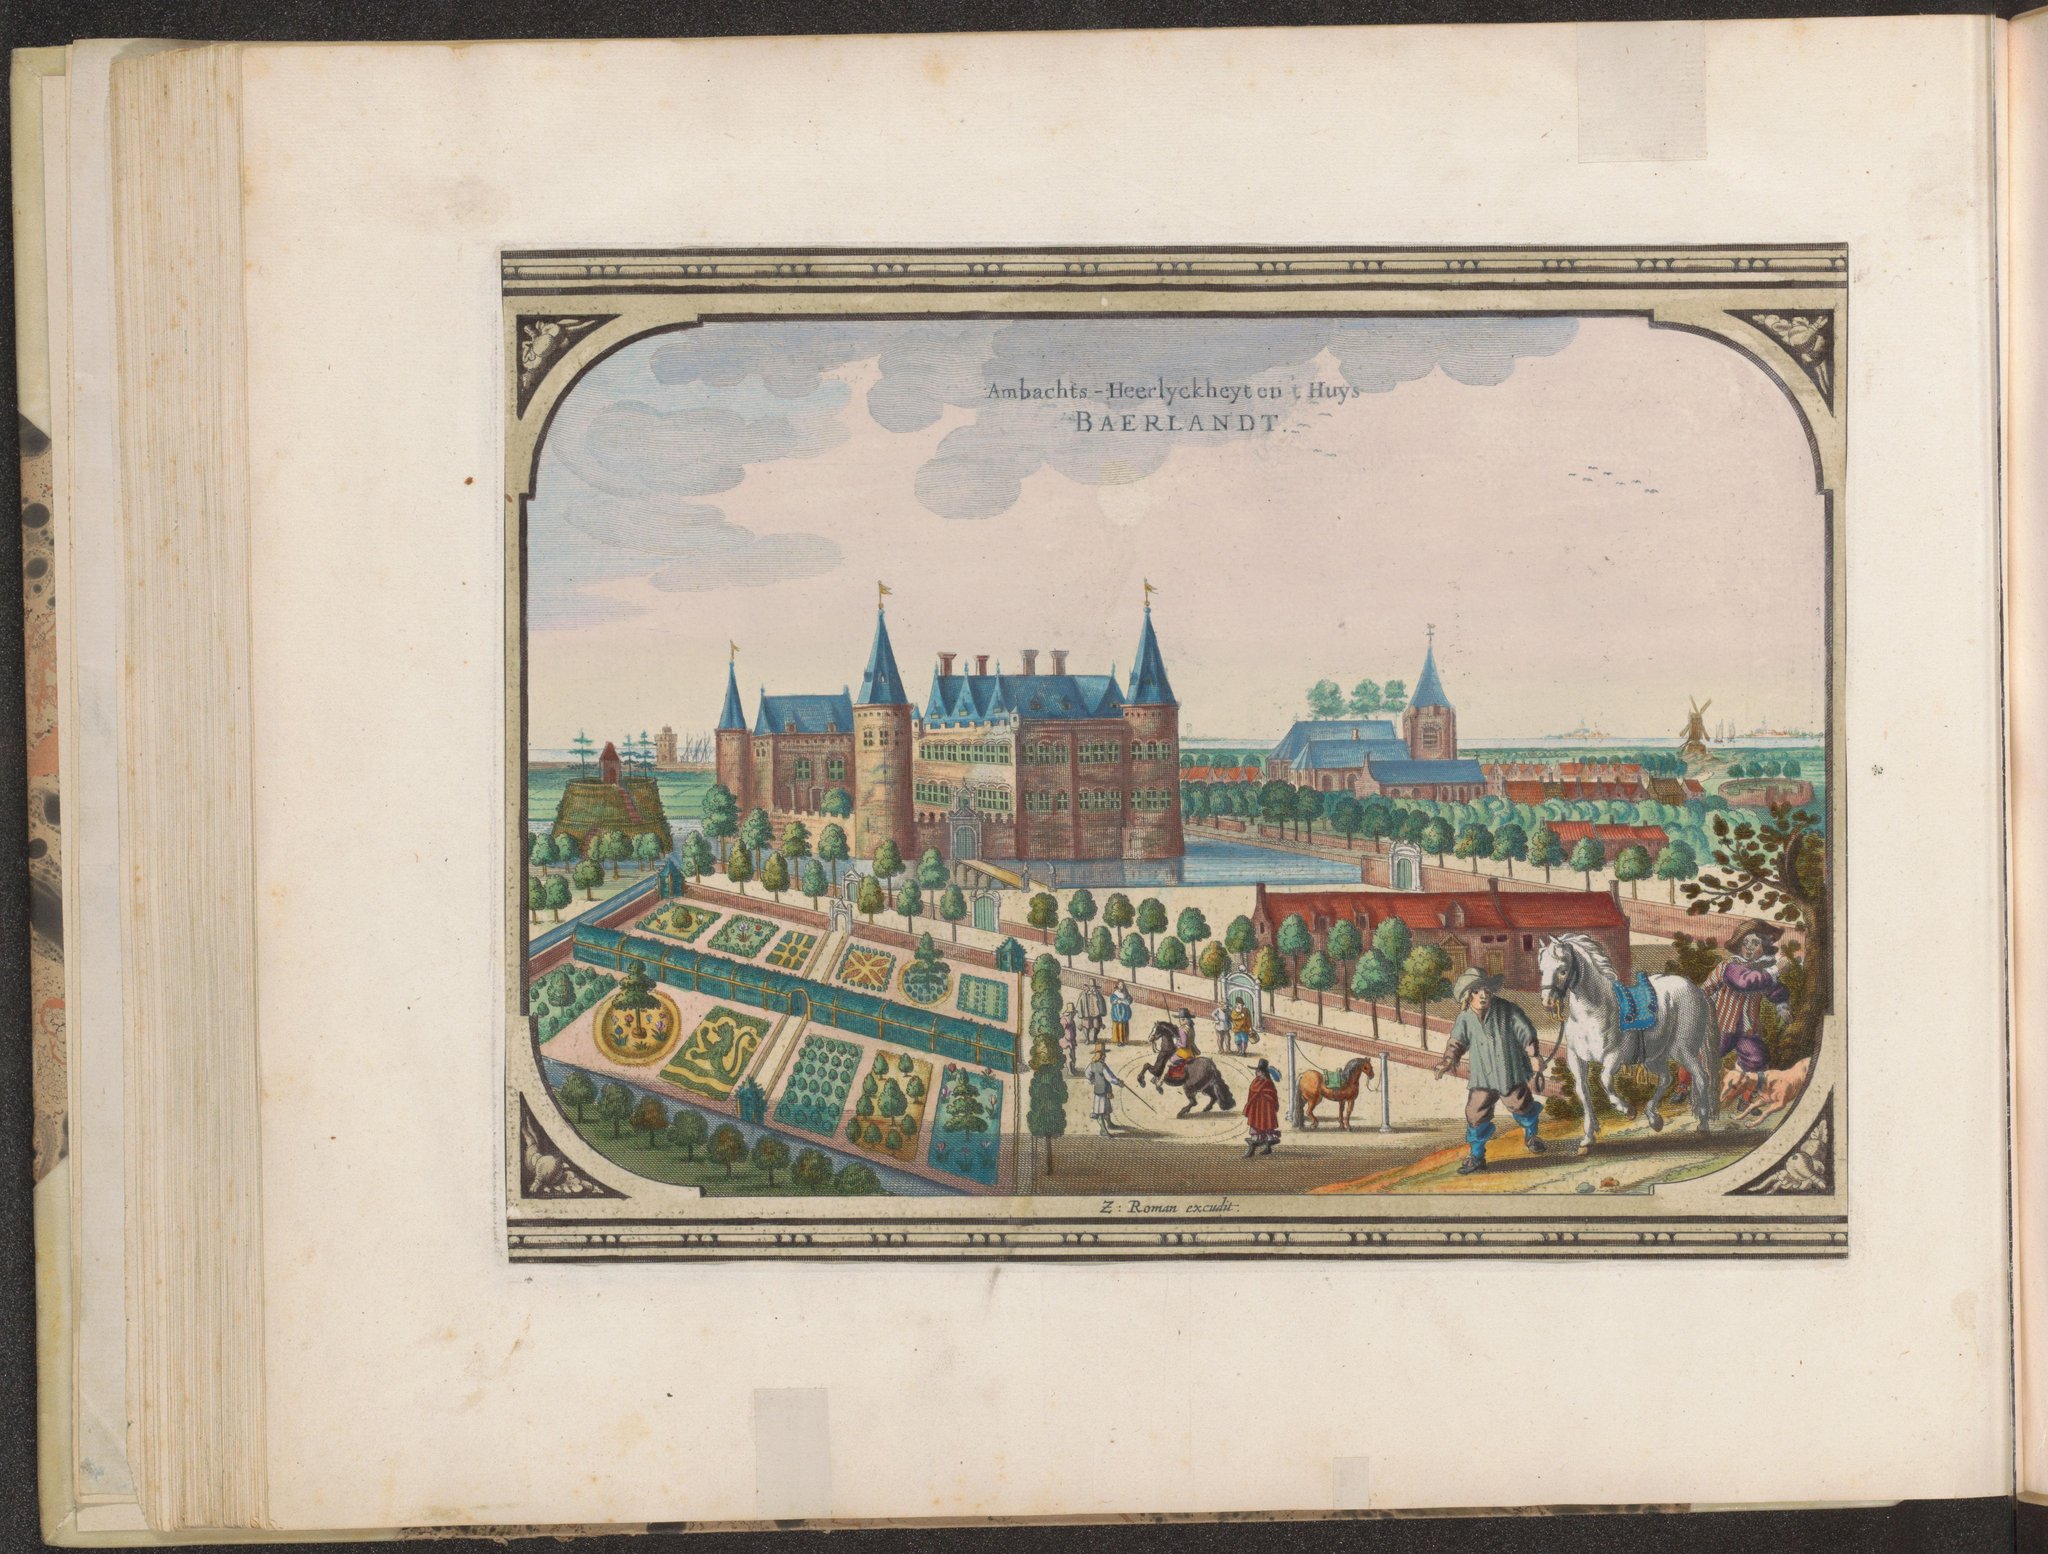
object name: album leaf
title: Speculum Zelandiae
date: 1662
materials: paper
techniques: etching, hand coloring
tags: city-view, and landscape with man-made constructions, castle, garden, training of horses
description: Gezicht op Slot Baarland (het Hof van Baarland) en zijn tuinen. Eén van de tuinen is aangelegd in de vorm van het wapen van Zeeland. Op de voorgrond worden paarden getraind. De prent maakt deel uit van een album.